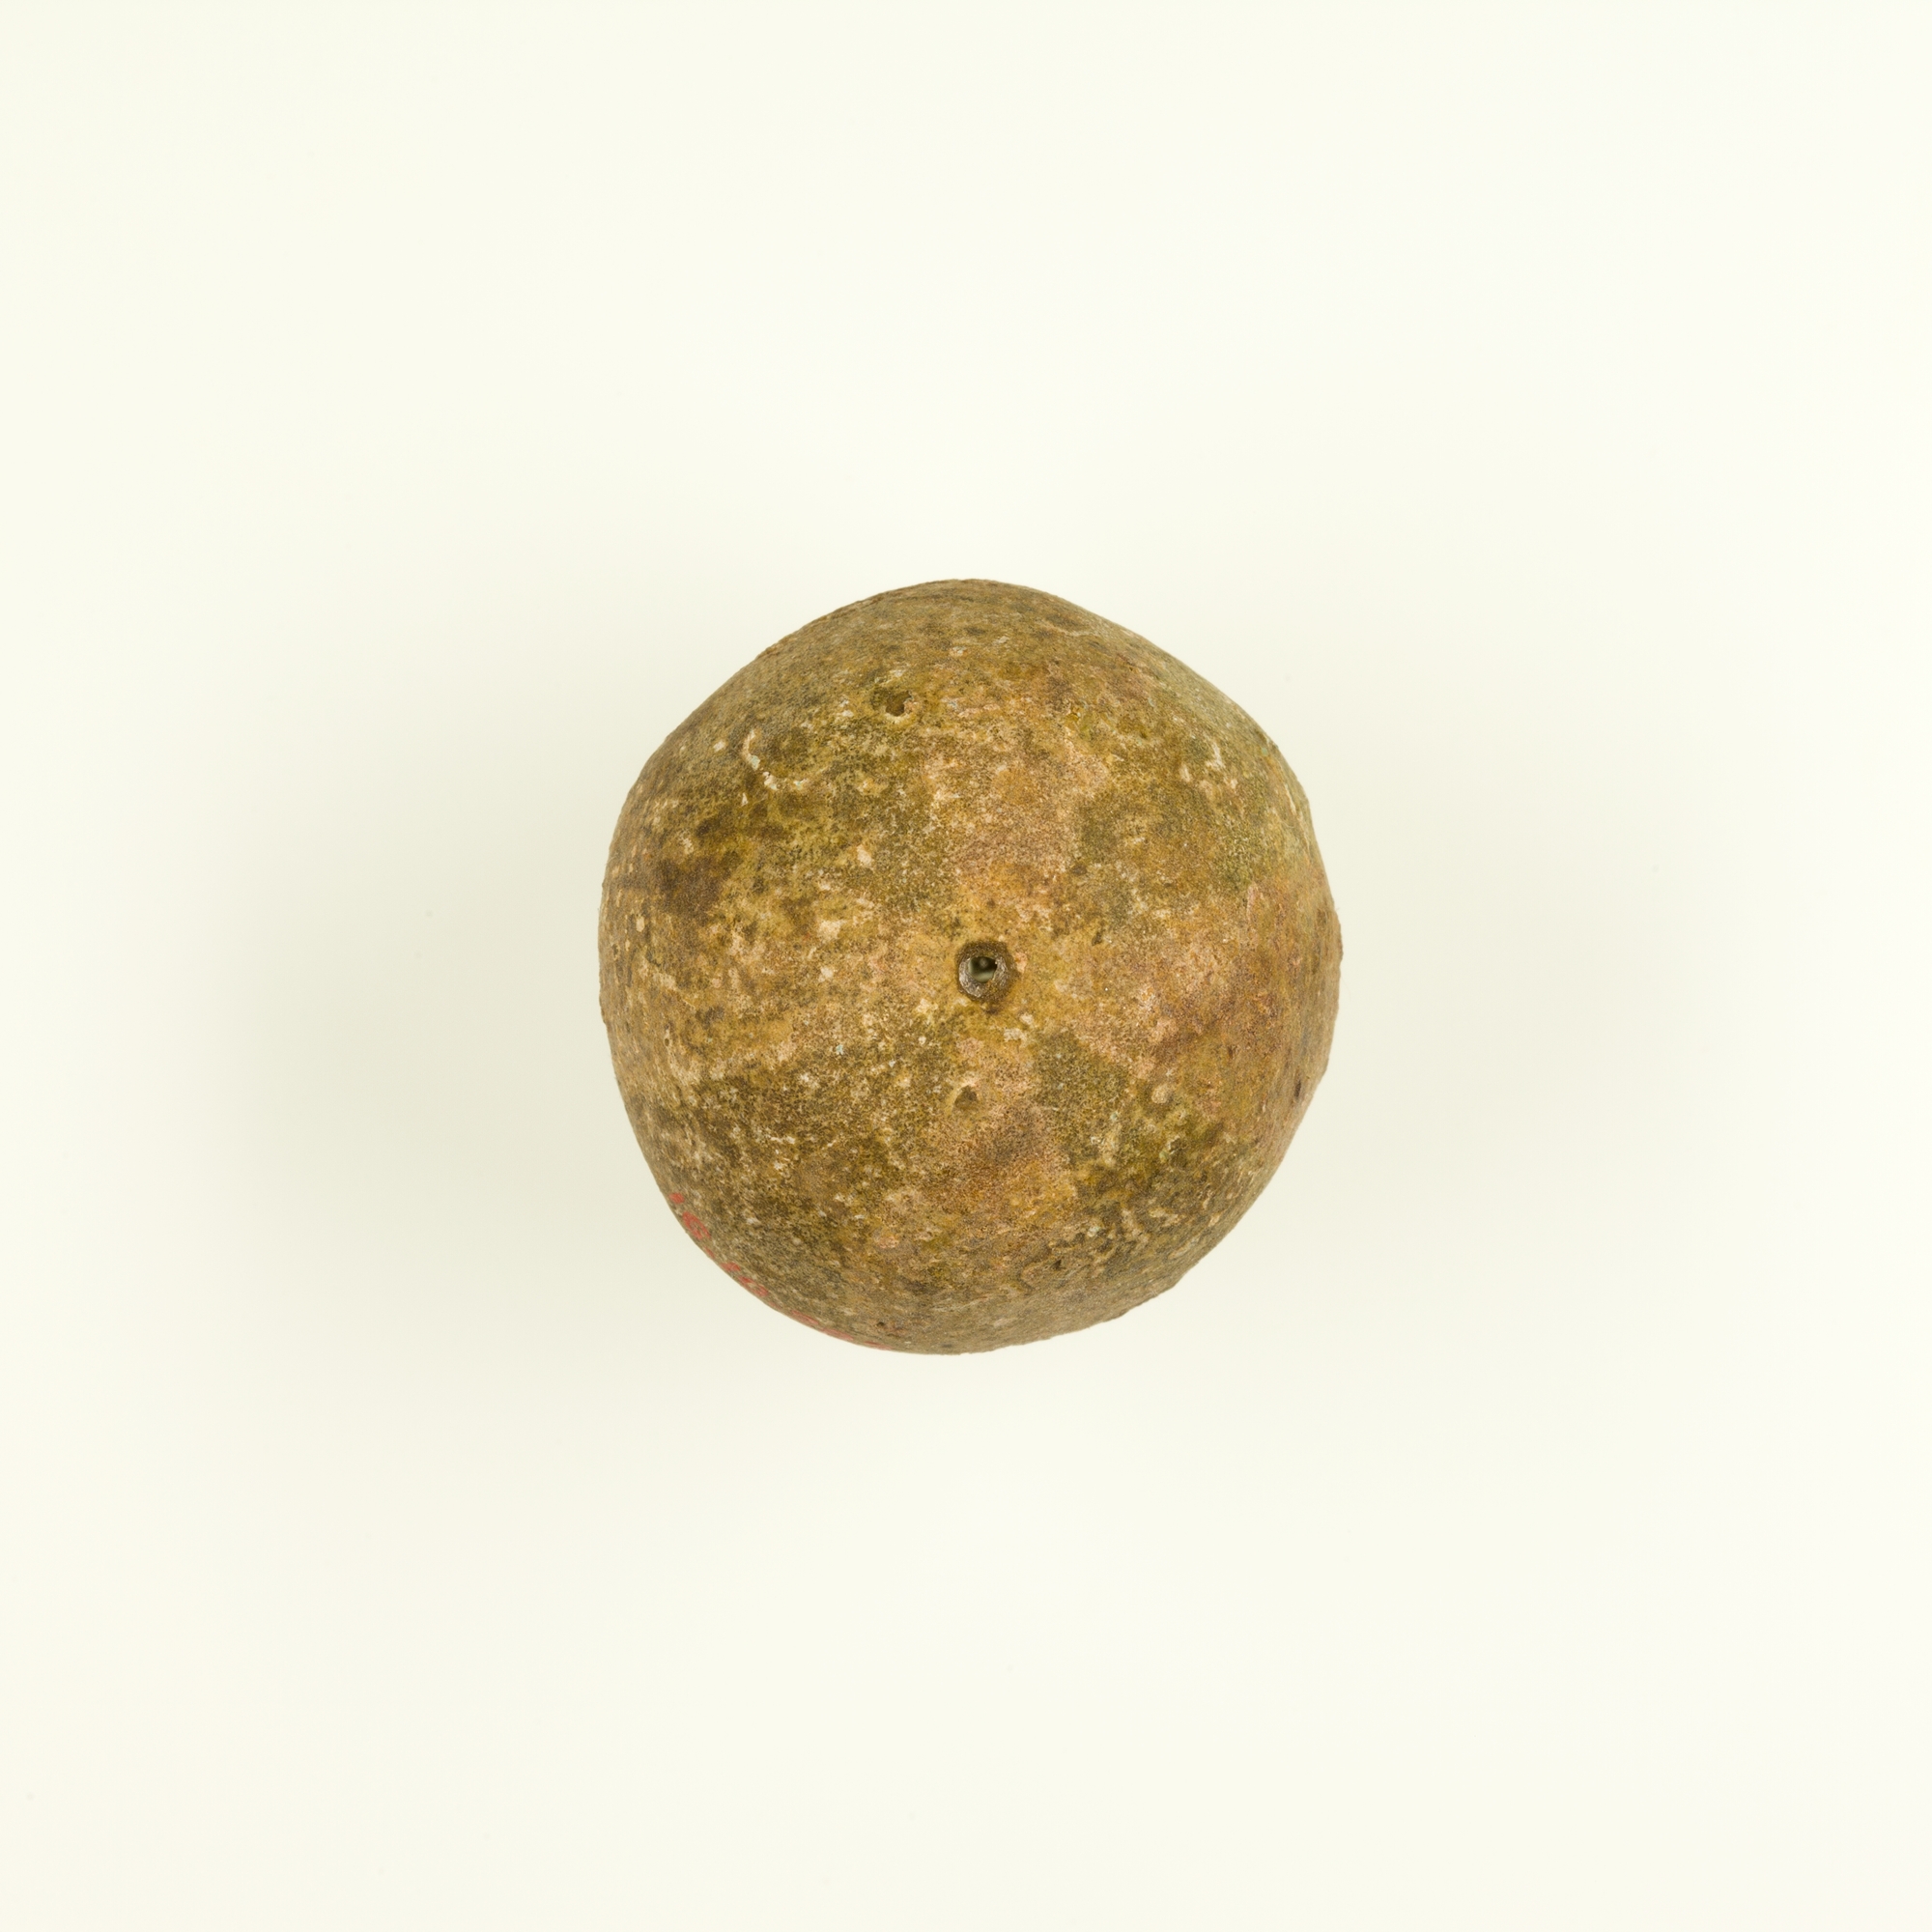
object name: bead, ball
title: Ball bead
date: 1635-1458 BCE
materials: faience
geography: egypt